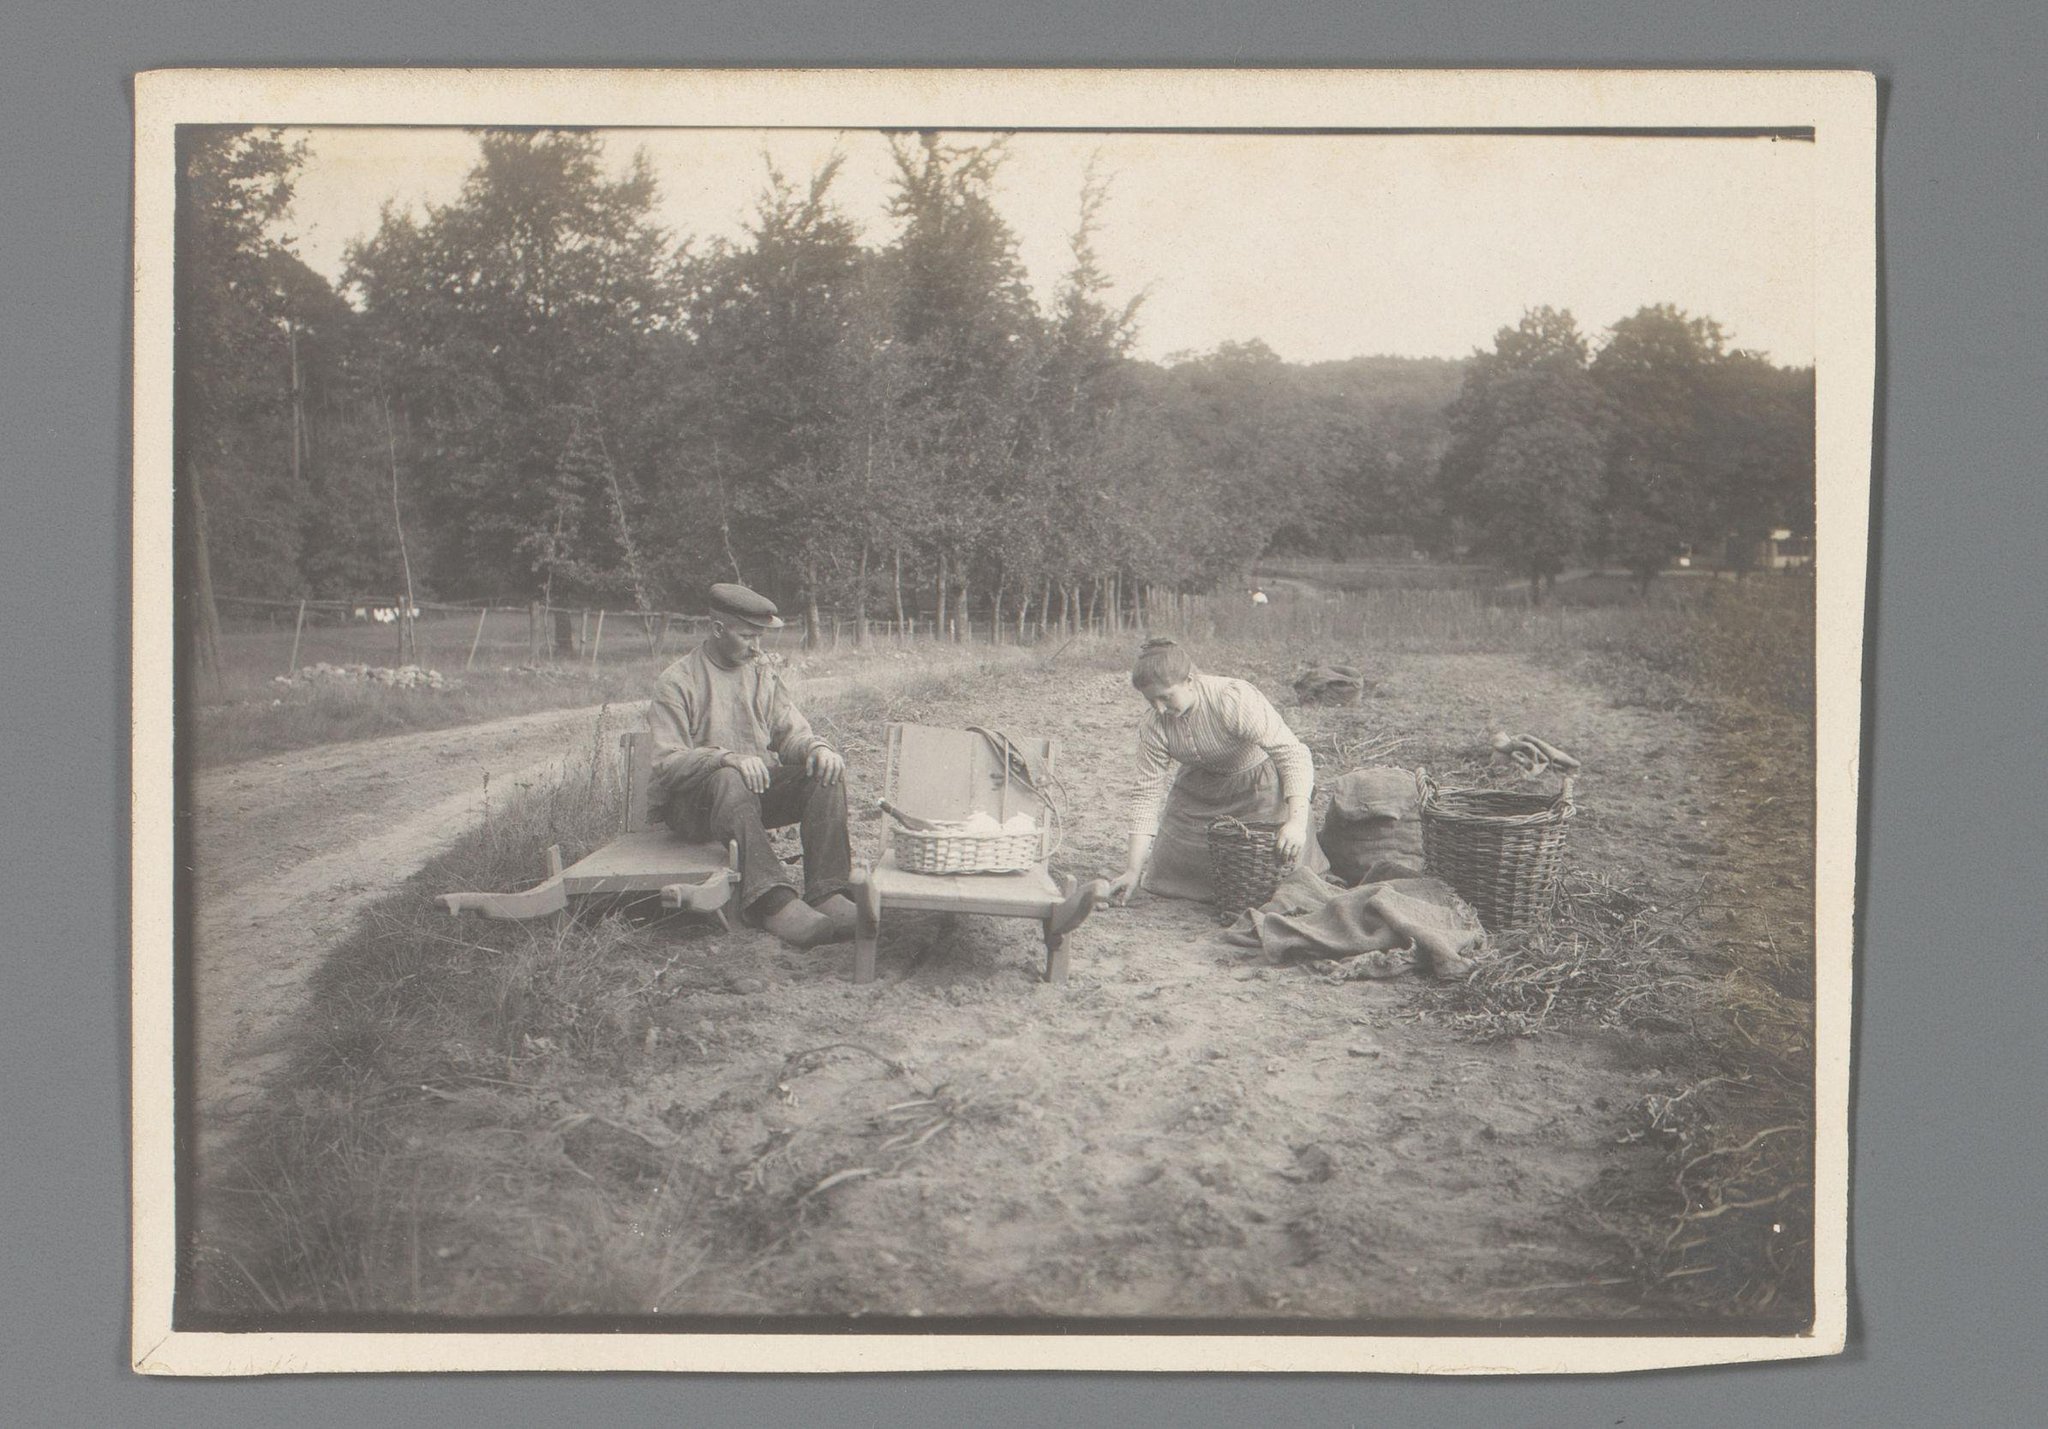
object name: photograph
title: Man en vrouw werkend in een boslandschap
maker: willem de jong (fotograaf)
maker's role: arts, fotograaf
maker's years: 1864-1918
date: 1895-1918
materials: paper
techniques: gelatin silver print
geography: netherlands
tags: forest, wood, labour